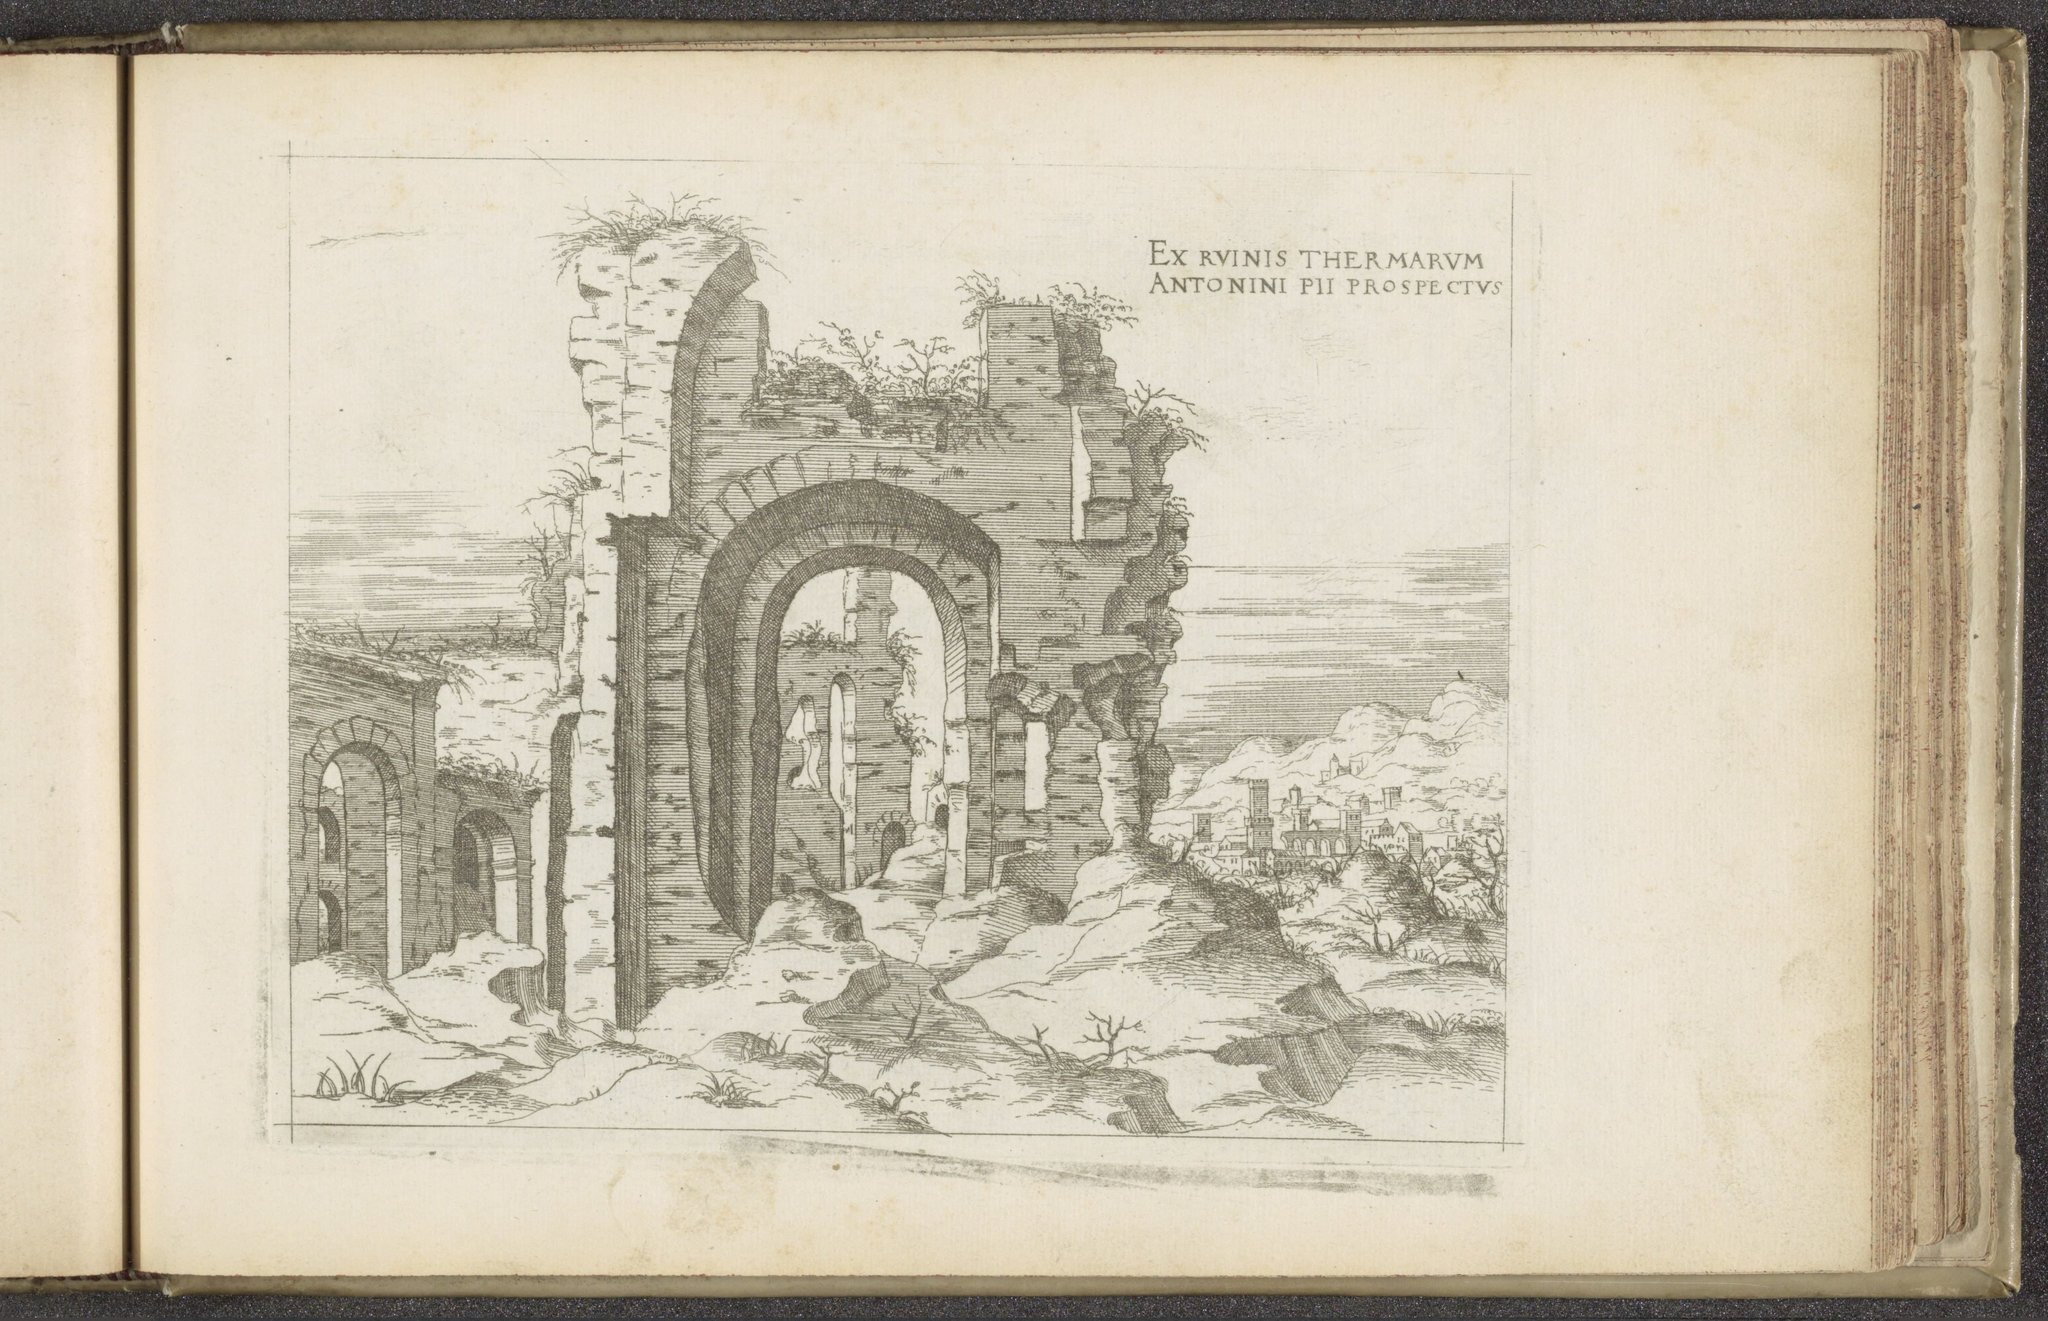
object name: print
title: Ex Ruinis Thermarum Antonini Pii Prospectus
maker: jacques androuet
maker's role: draughtsman, print maker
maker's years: 1515-1584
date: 1551-1584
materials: paper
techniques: etching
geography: france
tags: ruin of a building ~ architecture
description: Gezicht op de ruïnes van de Thermen van Caracalla. Deze prent maakt deel uit van een album.